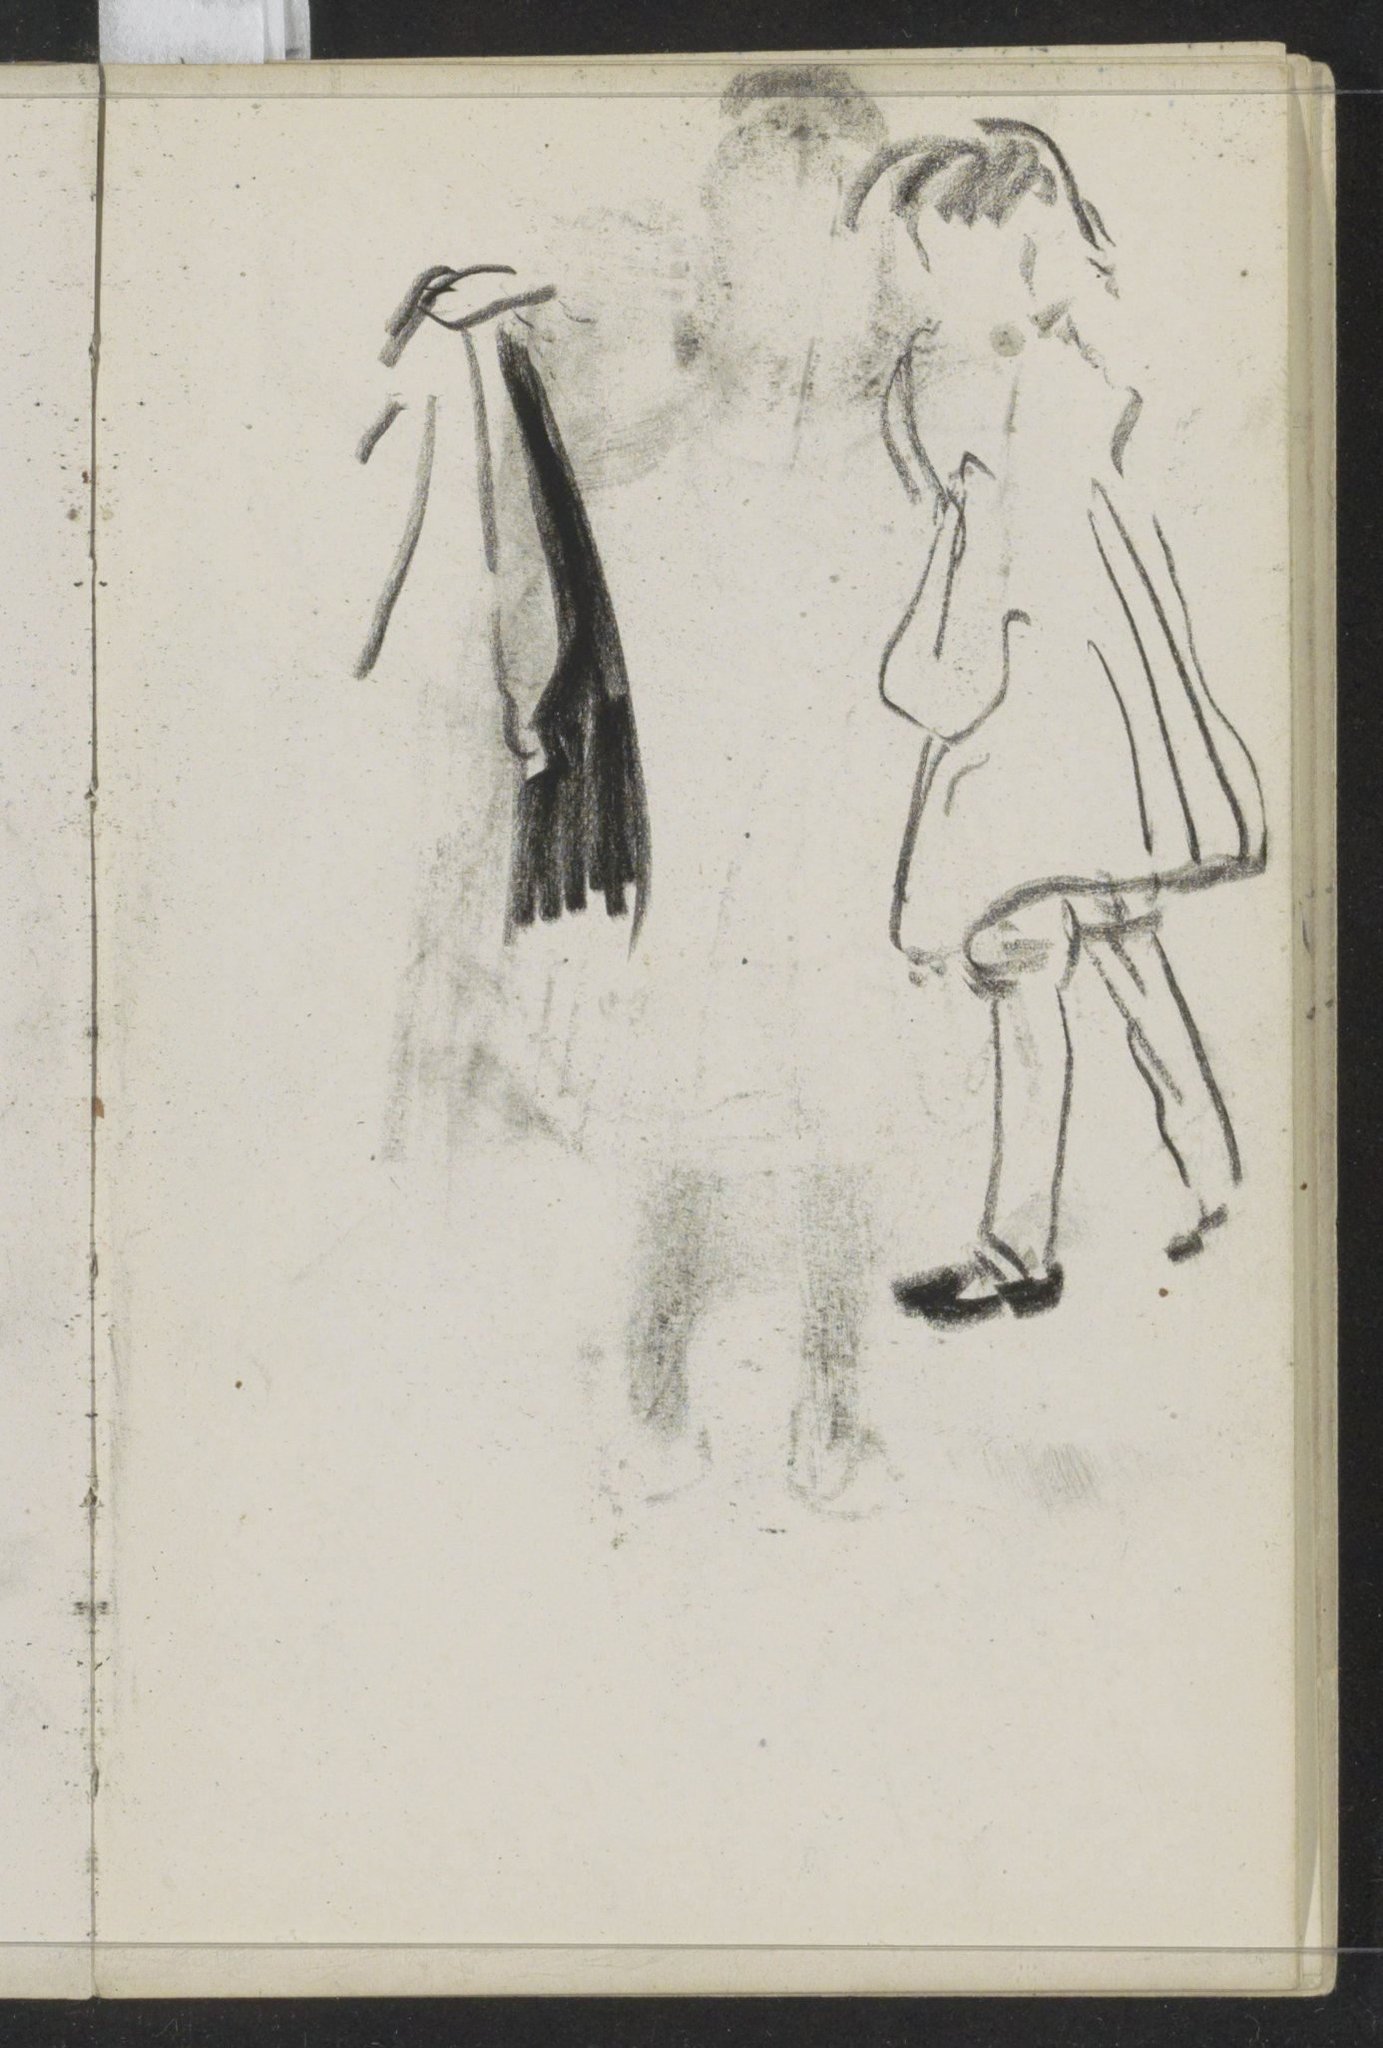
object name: sketchbook leaf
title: Lopend meisje in een jurk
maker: carel adolph lion cachet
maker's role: draughtsman, print maker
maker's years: 1864-1945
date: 1874-1945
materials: chalk, paper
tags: walking (+ young female (human being)), dress, gown (+ women's clothes)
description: Tevens een studie, mogelijk van een kledingstuk. Blad 24 recto uit een schetsboek met 41 bladen.